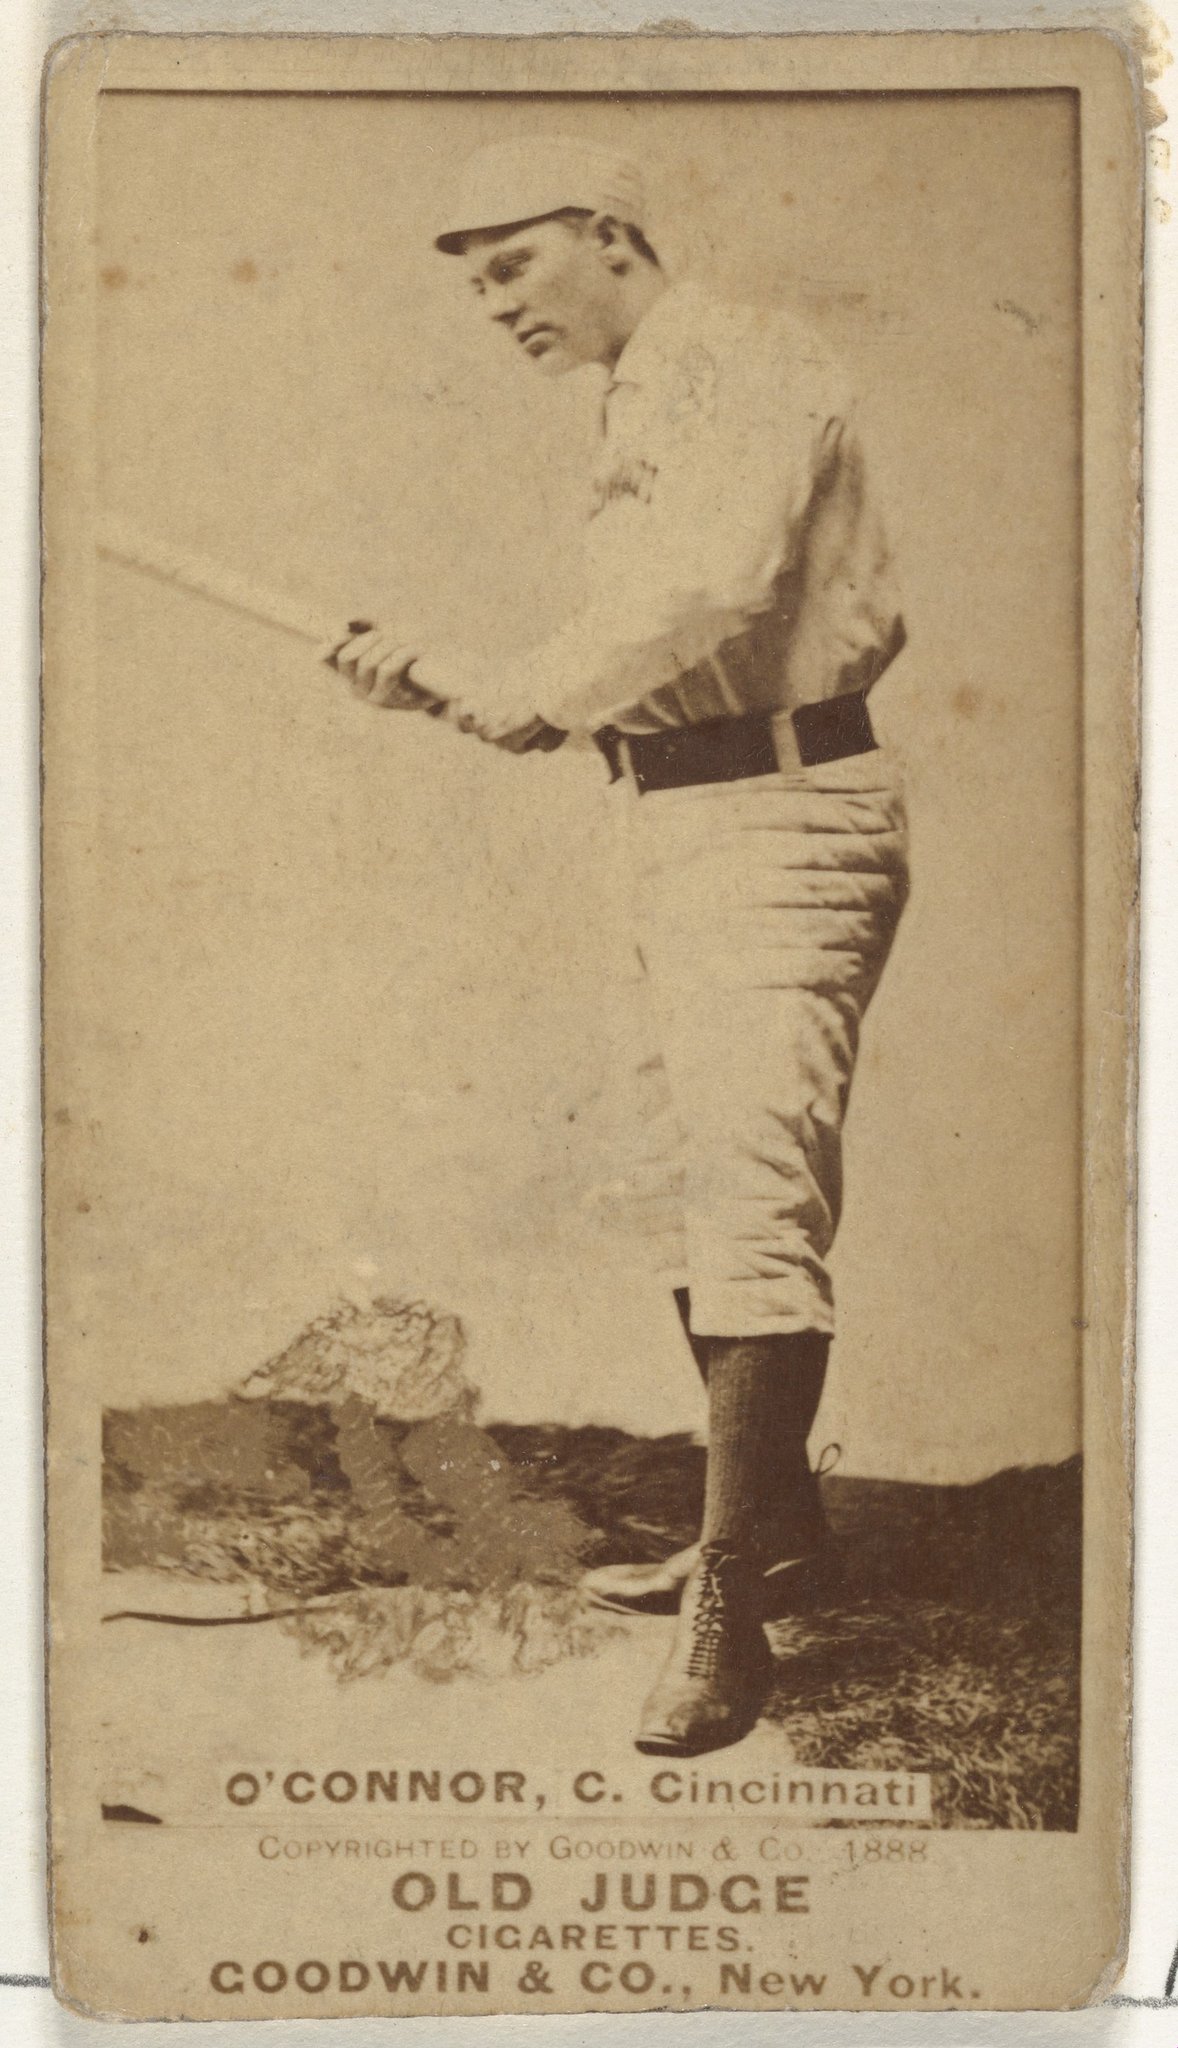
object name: baseball card, photograph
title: Jack "Peach Pie" O'Connor, Catcher, Cincinnati, from the Old Judge series (N172) for Old Judge Cigarettes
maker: goodwin & company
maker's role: publisher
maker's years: 1850-1950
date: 1888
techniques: albumen silver print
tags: men,portraits,baseball,athletes